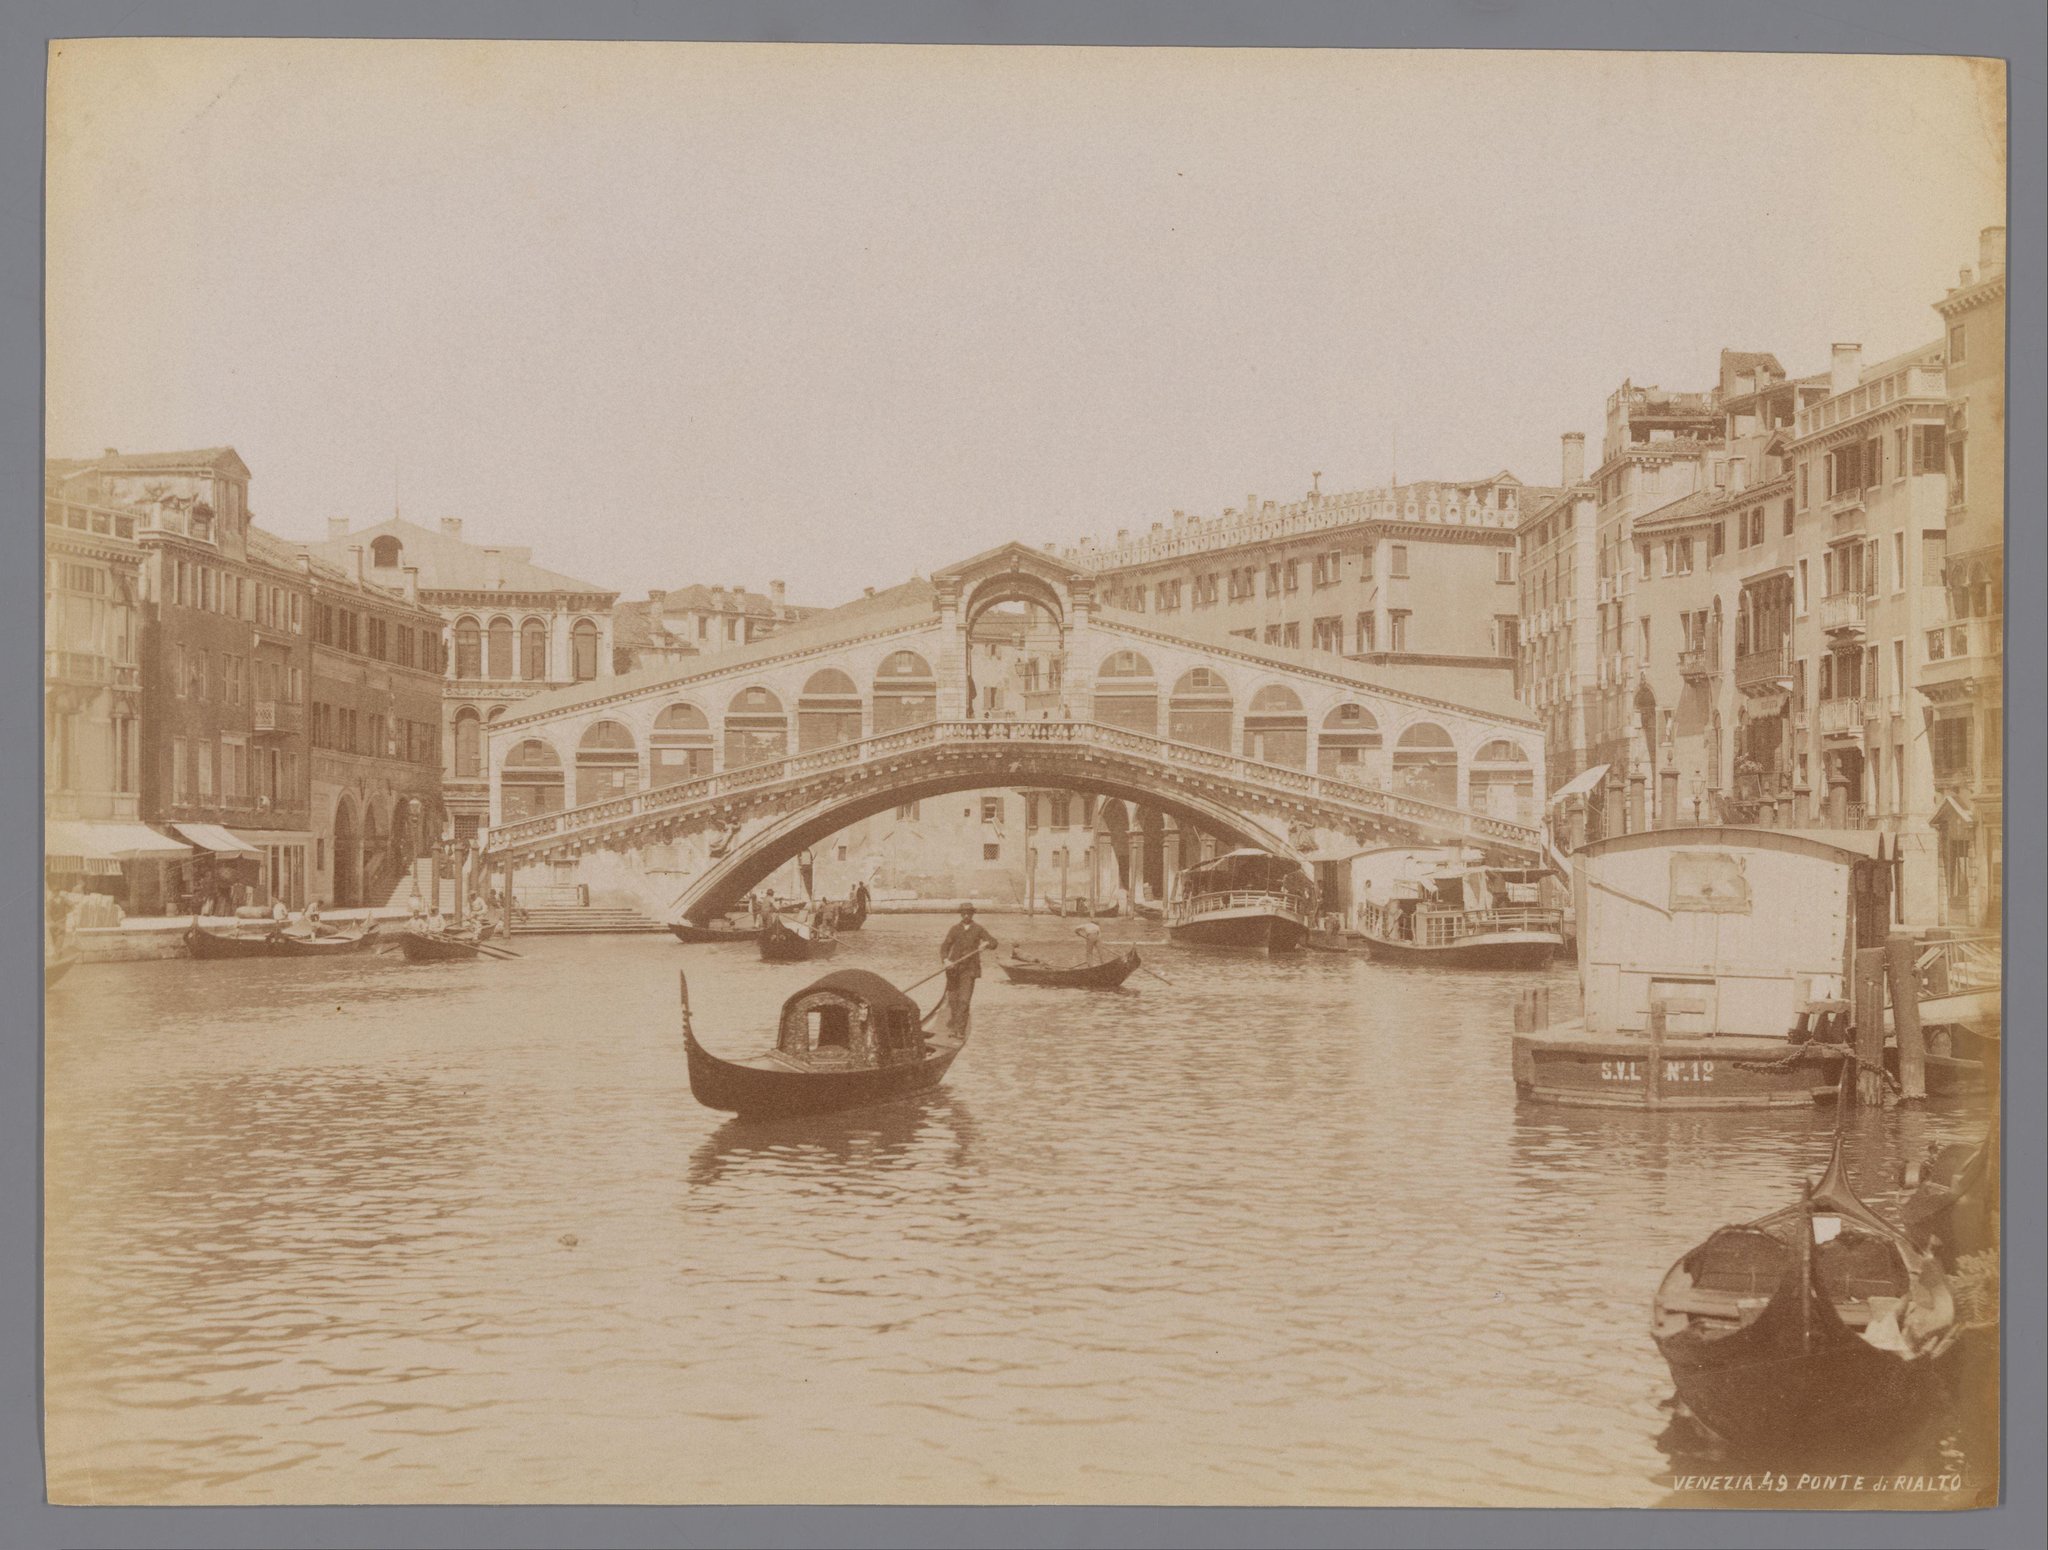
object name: photograph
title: Gezicht op de Rialtobrug te Venetië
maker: Anonymous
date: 1851-1900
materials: paper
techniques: albumen print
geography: venice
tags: bridge in city across river, canal, etc.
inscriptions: number: ‘49’